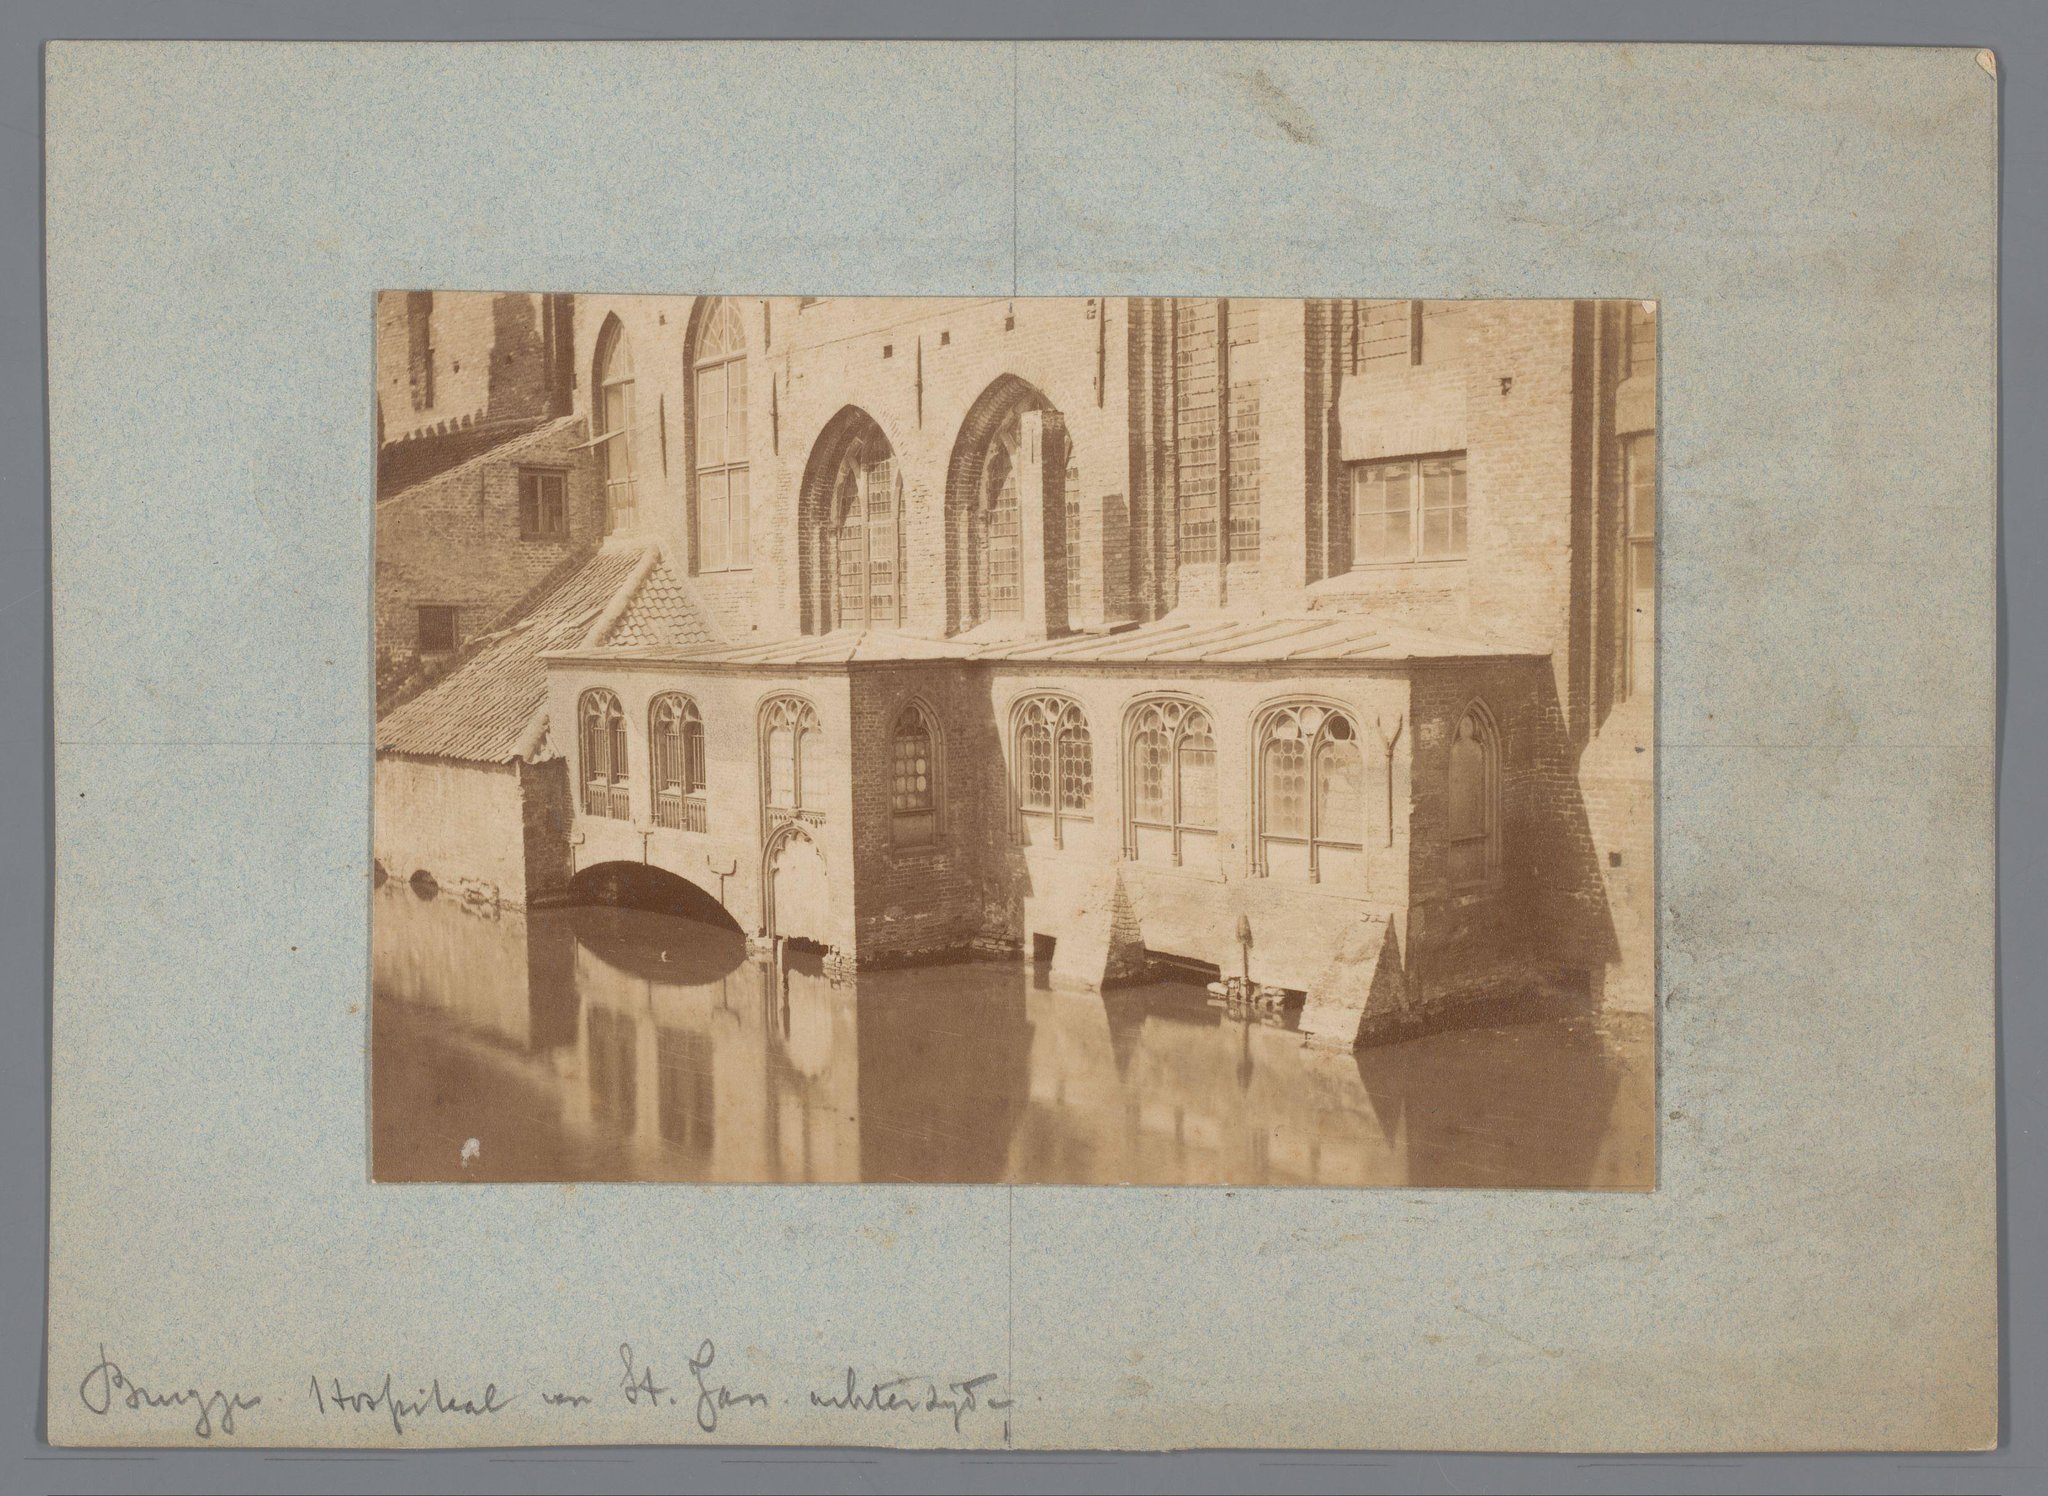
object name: photograph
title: Achterzijde van het Sint-Janshospitaal in Brugge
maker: Anonymous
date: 1860-1890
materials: cardboard, paper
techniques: albumen print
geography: bruges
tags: hospital